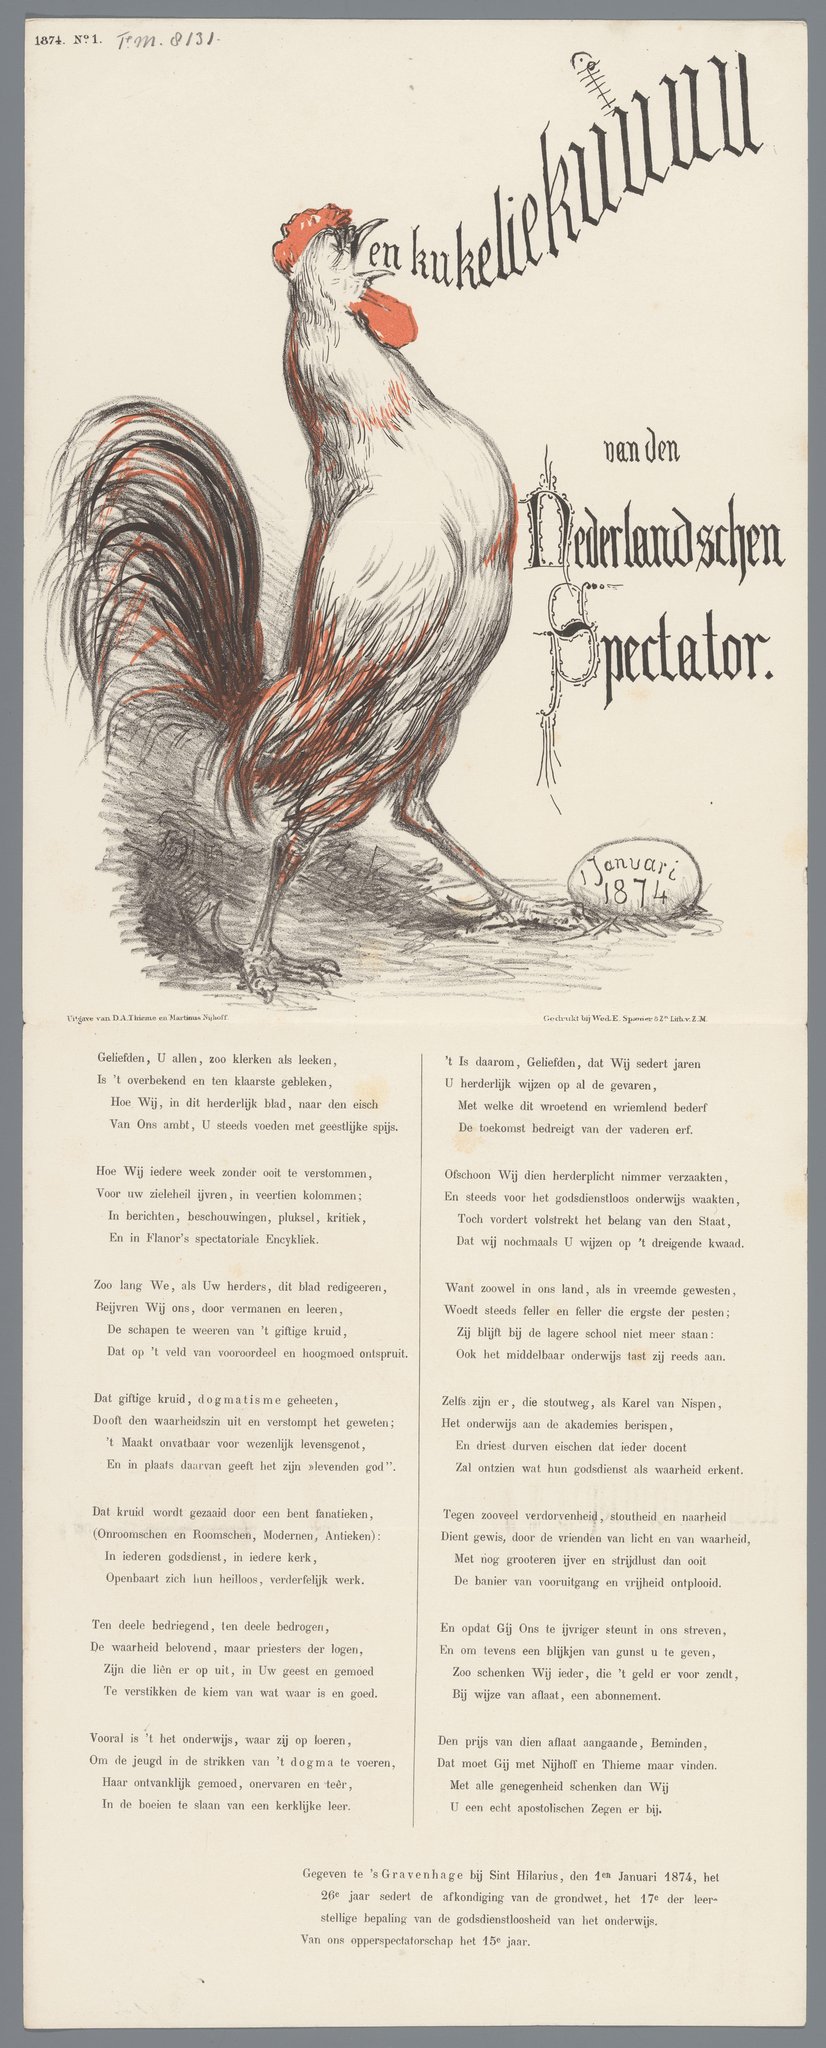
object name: print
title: Nieuwjaarsprent voor het jaar 1874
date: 1874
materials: paper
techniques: lithograph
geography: arnhem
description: Nieuwjaarsprent voor het jaar 1874. Bovenaan een grote haan met een nieuwjaarsvers, waaronder een herderlijke vermaning. Satire op de Ultramontijnen en hun eisen. Plaat verschenen bij het weekblad De Nederlandsche Spectator, nr. 1, 1874.